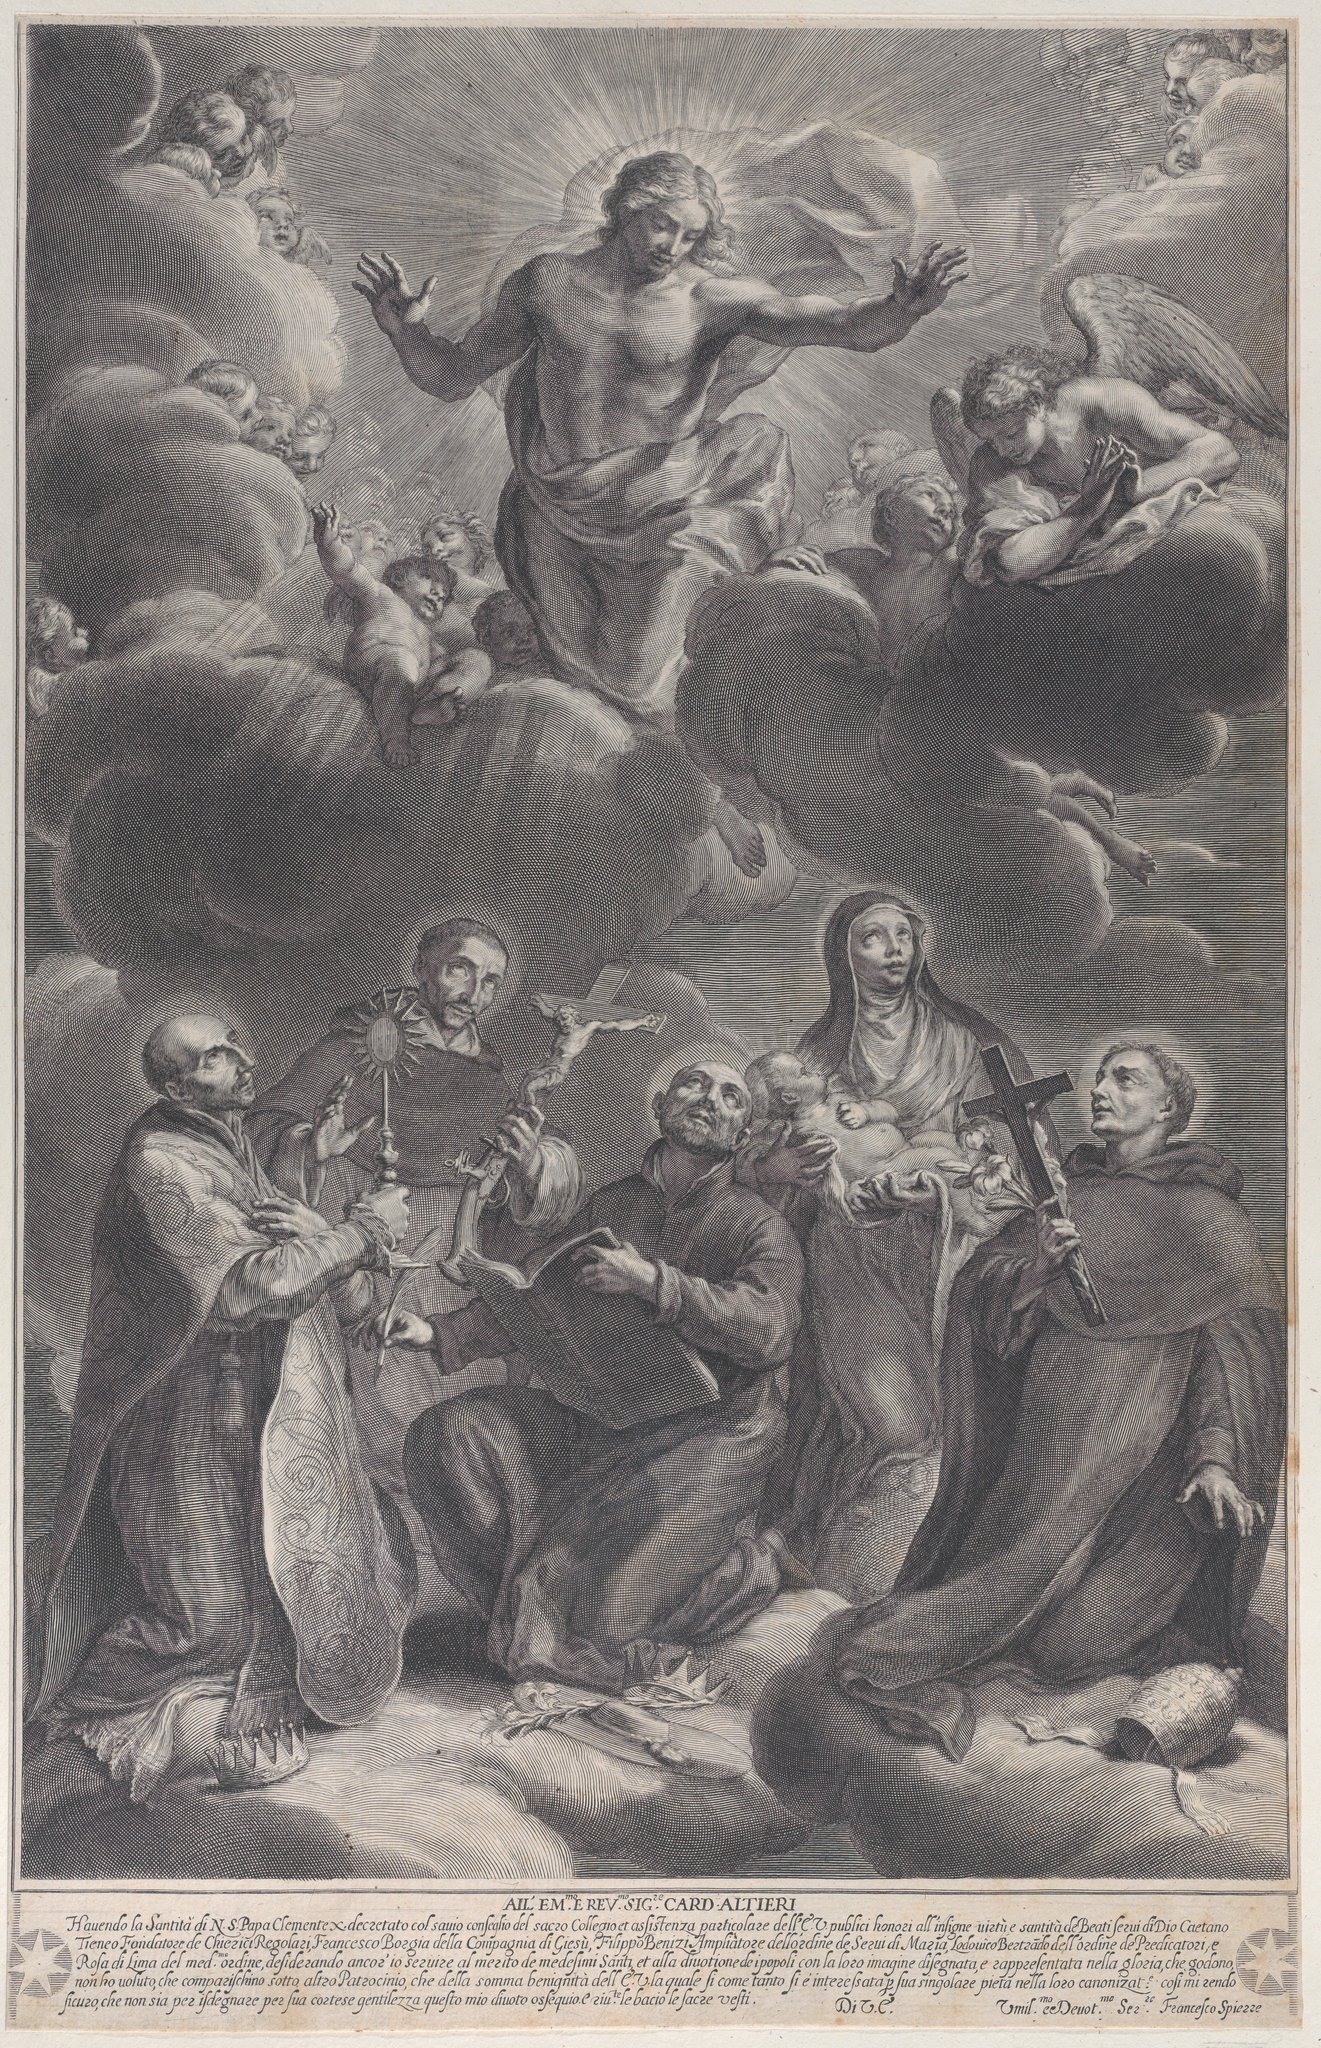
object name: print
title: Five saints kneeling and adoring Christ: Saint Francis Borgia, Saint Louis Bertrand, Saint Cajetan, Saint Rosa of Lima, and Saint Philip Benzi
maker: françois spierre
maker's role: artist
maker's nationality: french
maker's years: 1639-1681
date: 1671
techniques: engraving